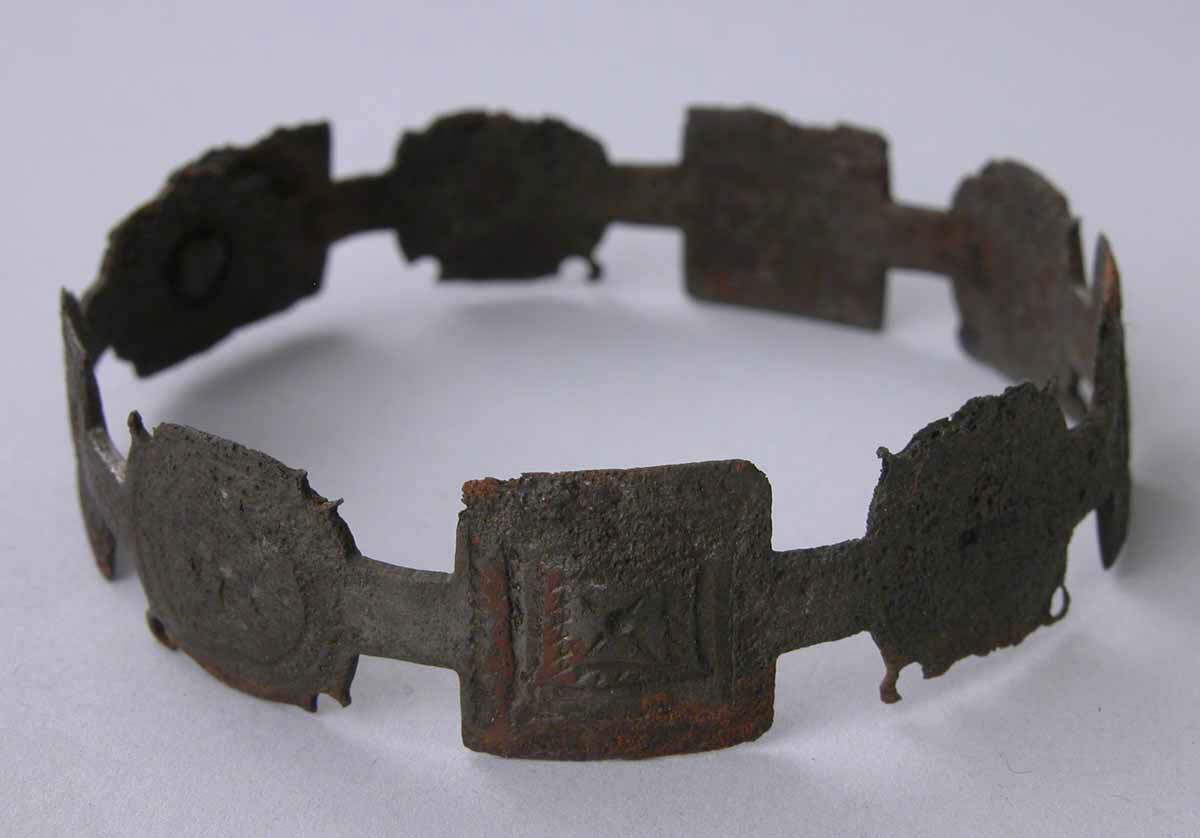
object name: bracelet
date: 501-800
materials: iron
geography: egypt